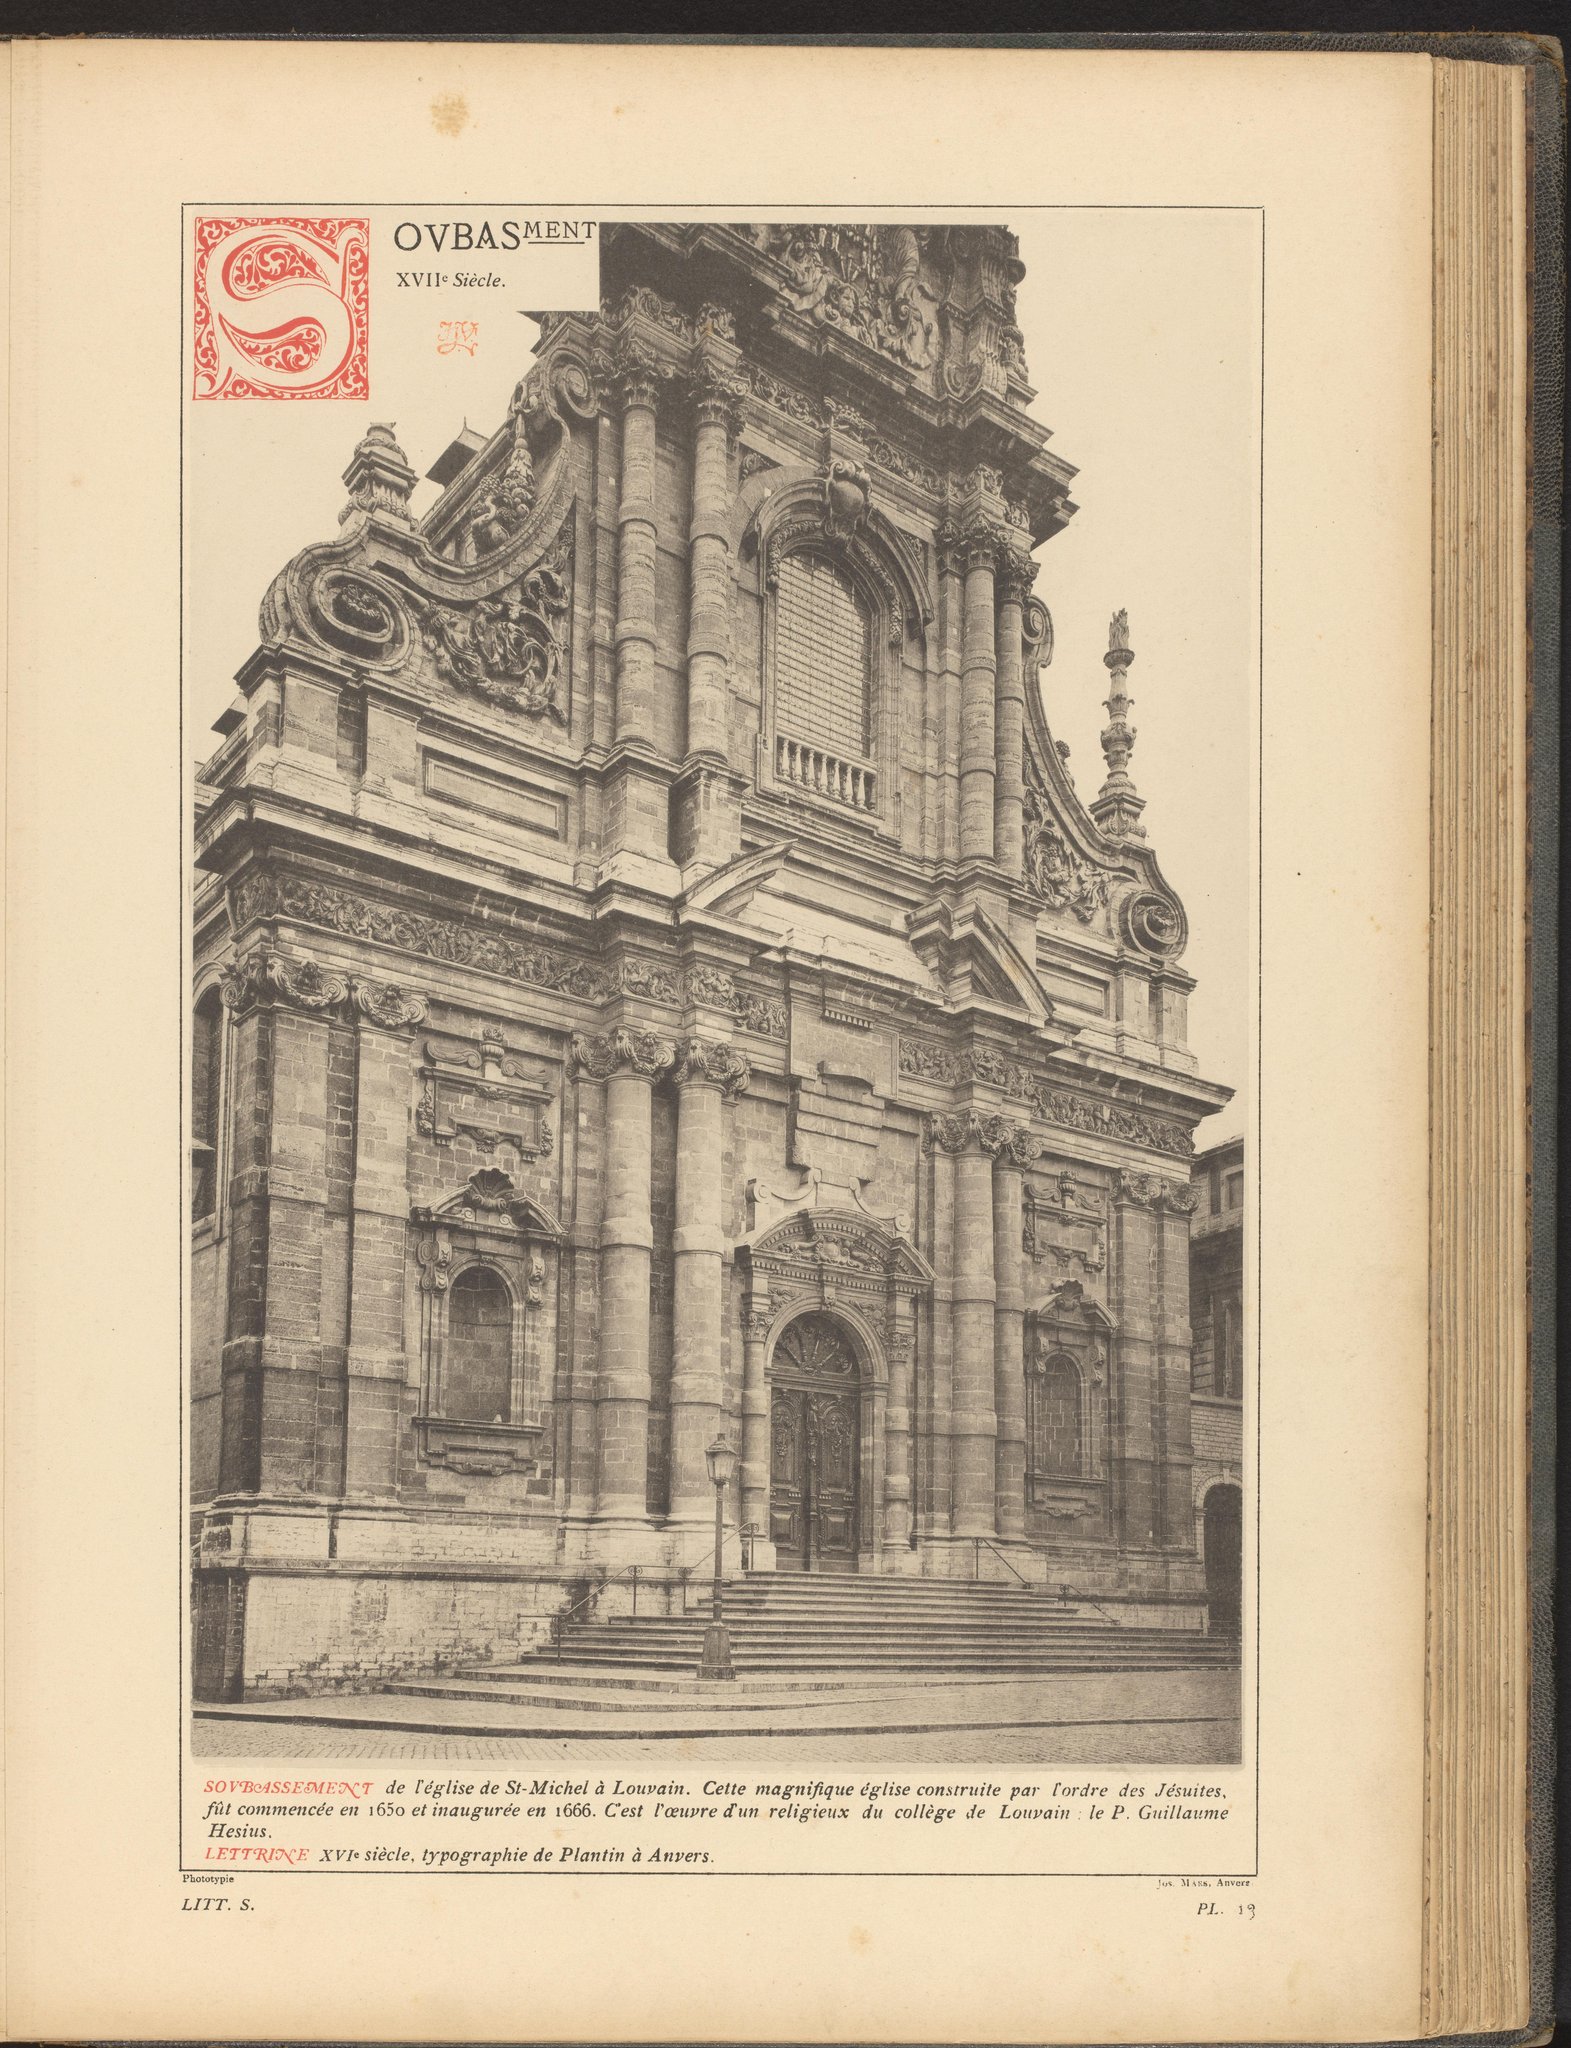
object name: photomechanical print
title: Sint-Michielskerk te Leuven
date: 1876-1881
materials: paper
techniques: photograph, photolithography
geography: leuven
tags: church (exterior)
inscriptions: inscription: ‘SOUBASSEMENT de l'église (...)’, inscription: ‘LITT. S. - PL. 13.’, monogram: ‘JJvY’